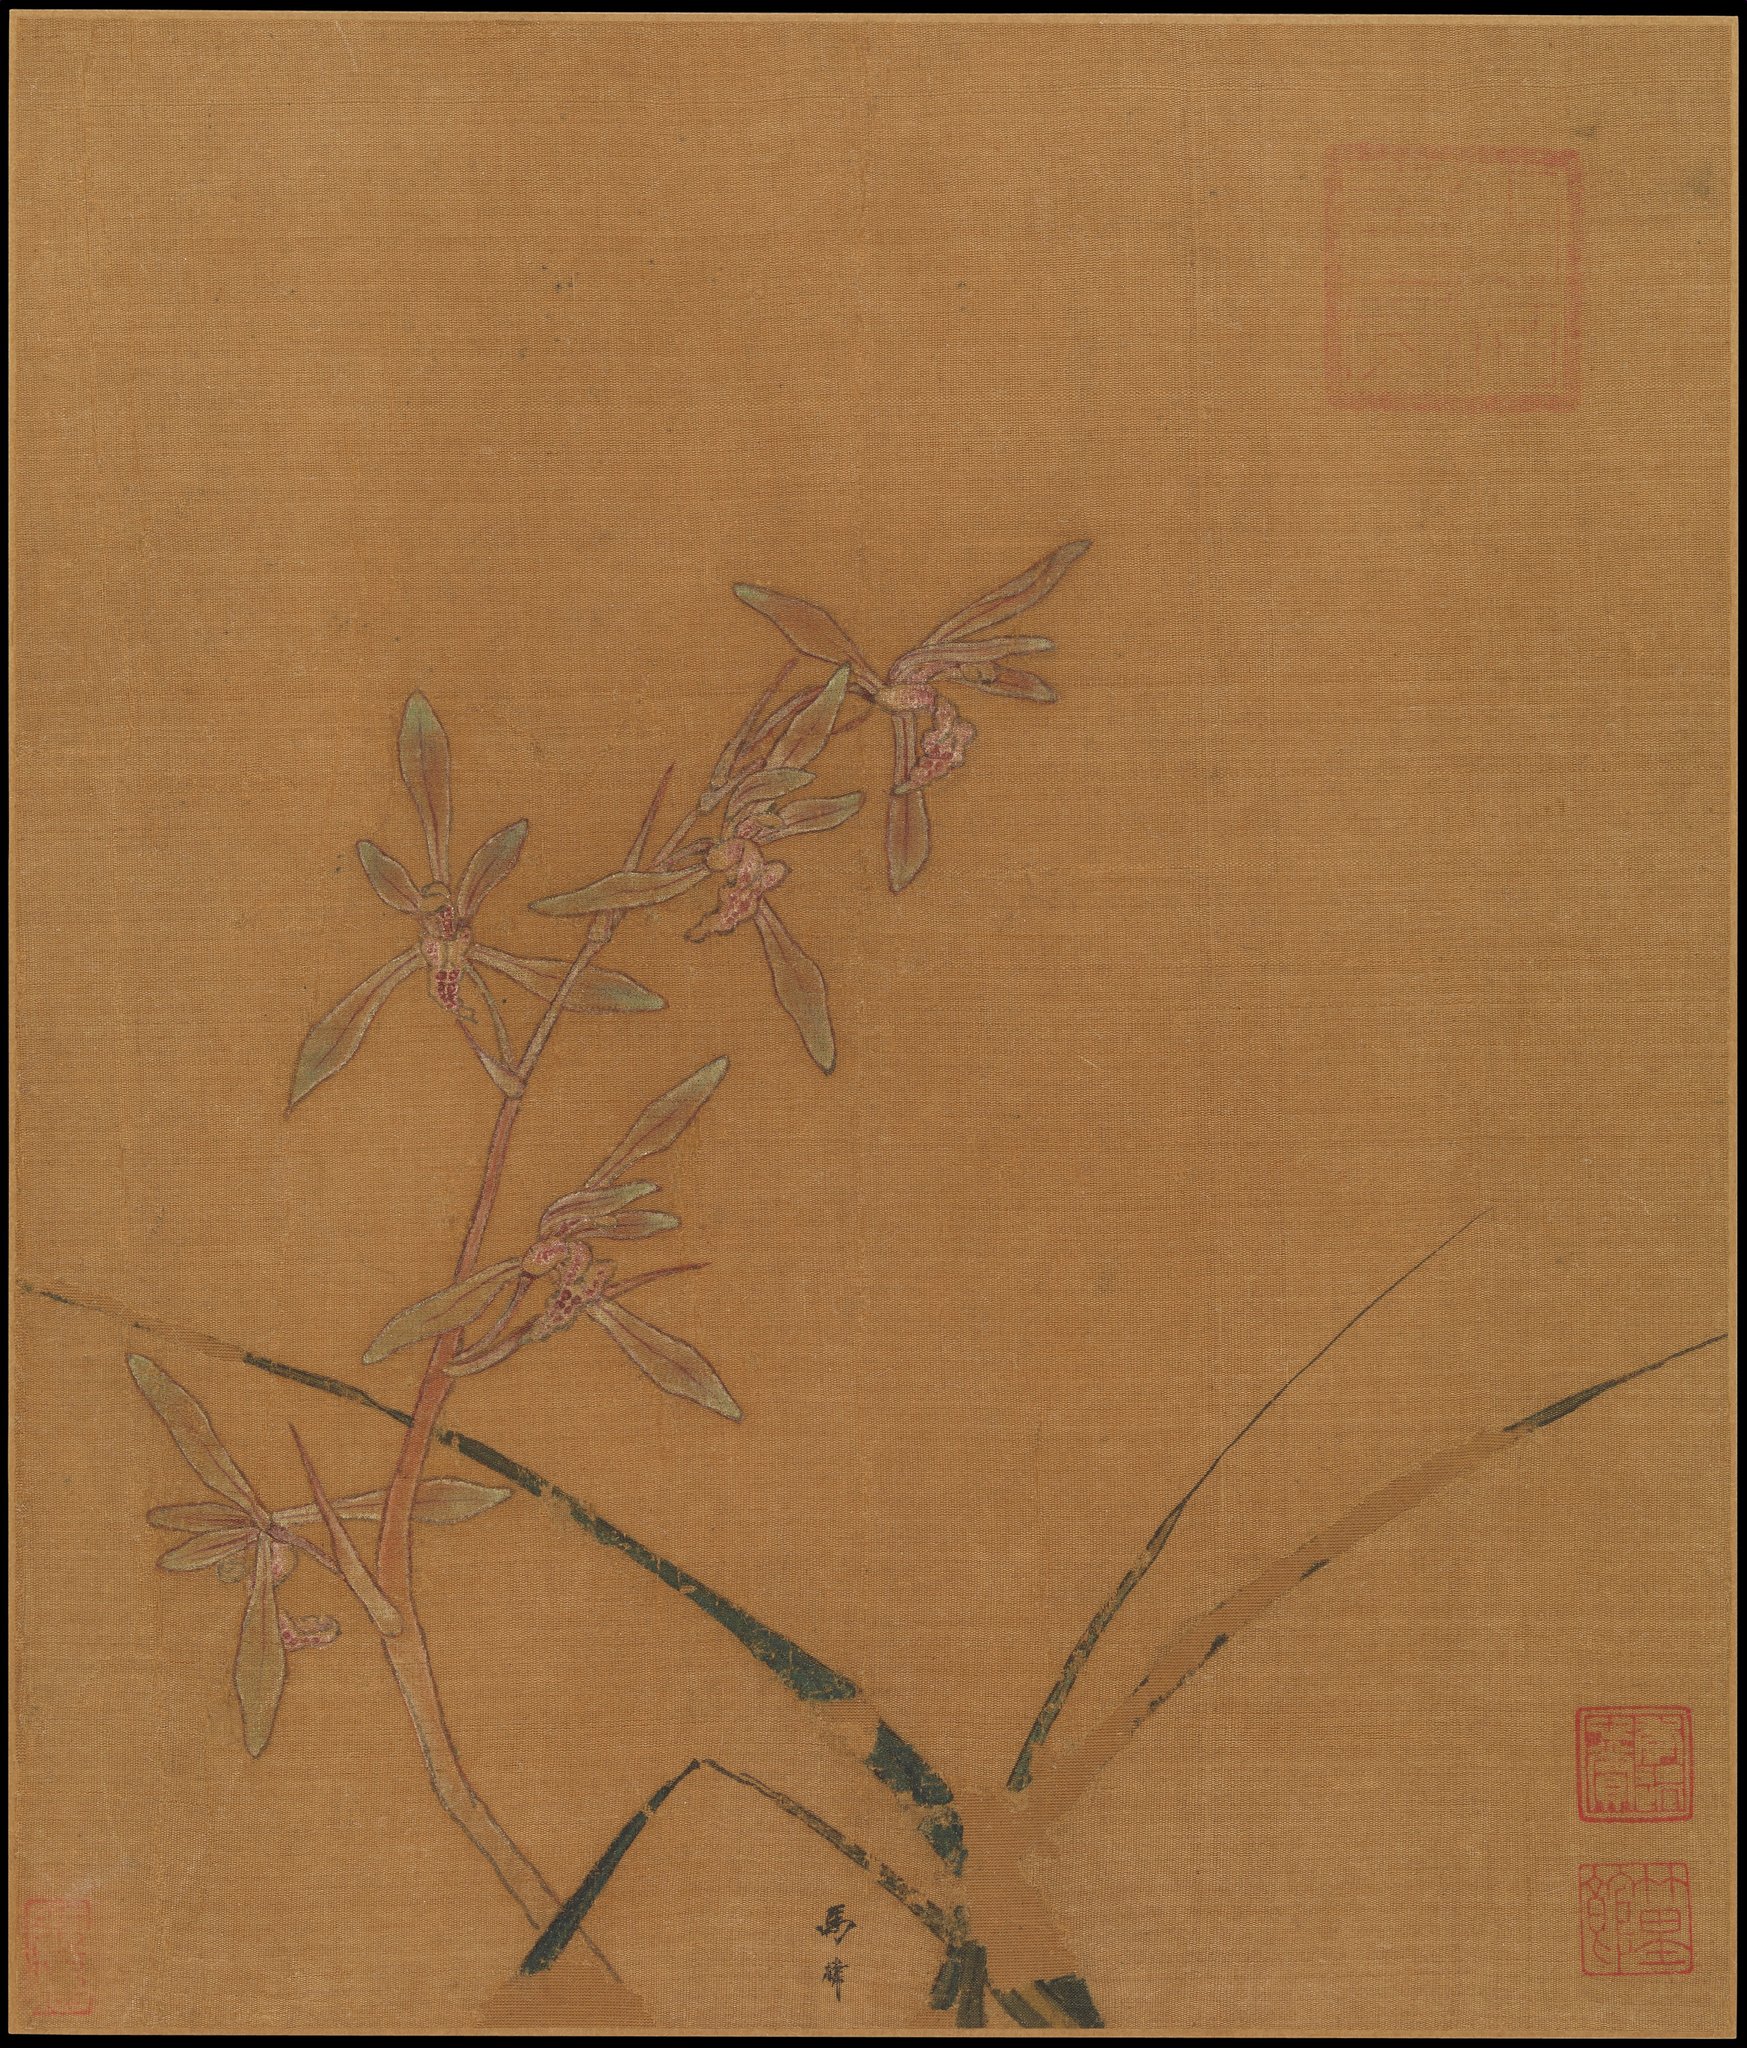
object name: album leaf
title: Orchids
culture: chinese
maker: ma lin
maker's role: artist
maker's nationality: chinese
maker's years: 1180-1256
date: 1226-1250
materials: ink, silk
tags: orchids